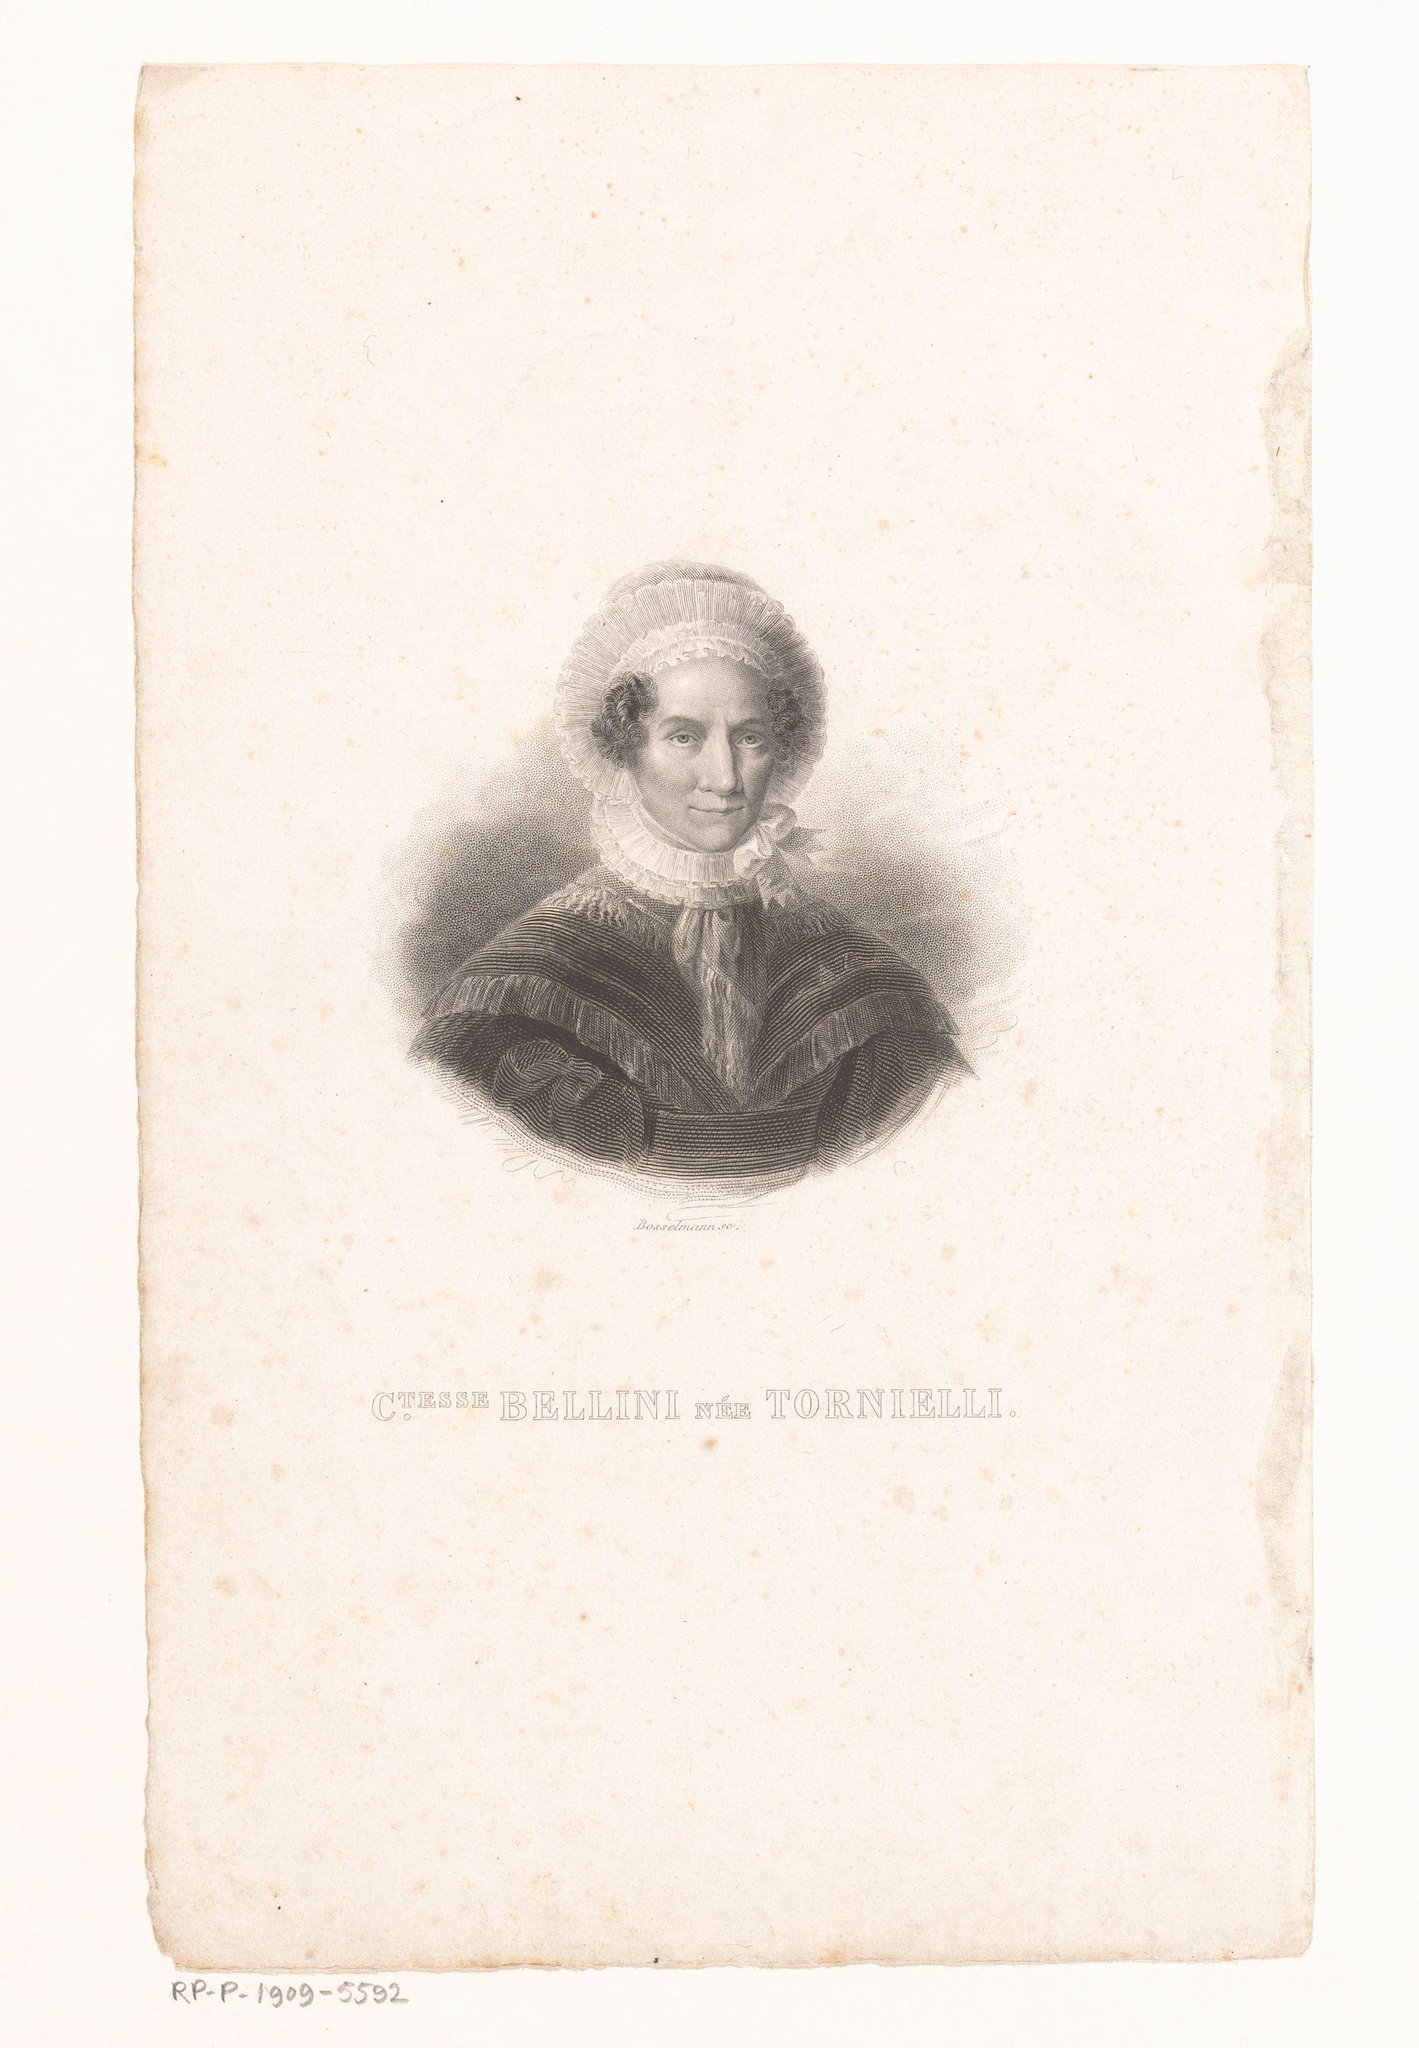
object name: print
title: Ctesse Bellini neé Tornielli.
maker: a. bosselman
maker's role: print maker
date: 1825-1841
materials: paper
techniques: engraving, etching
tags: historical persons, nobility and patriciate; chivalry, knighthood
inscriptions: collector's mark: Lugt 2228